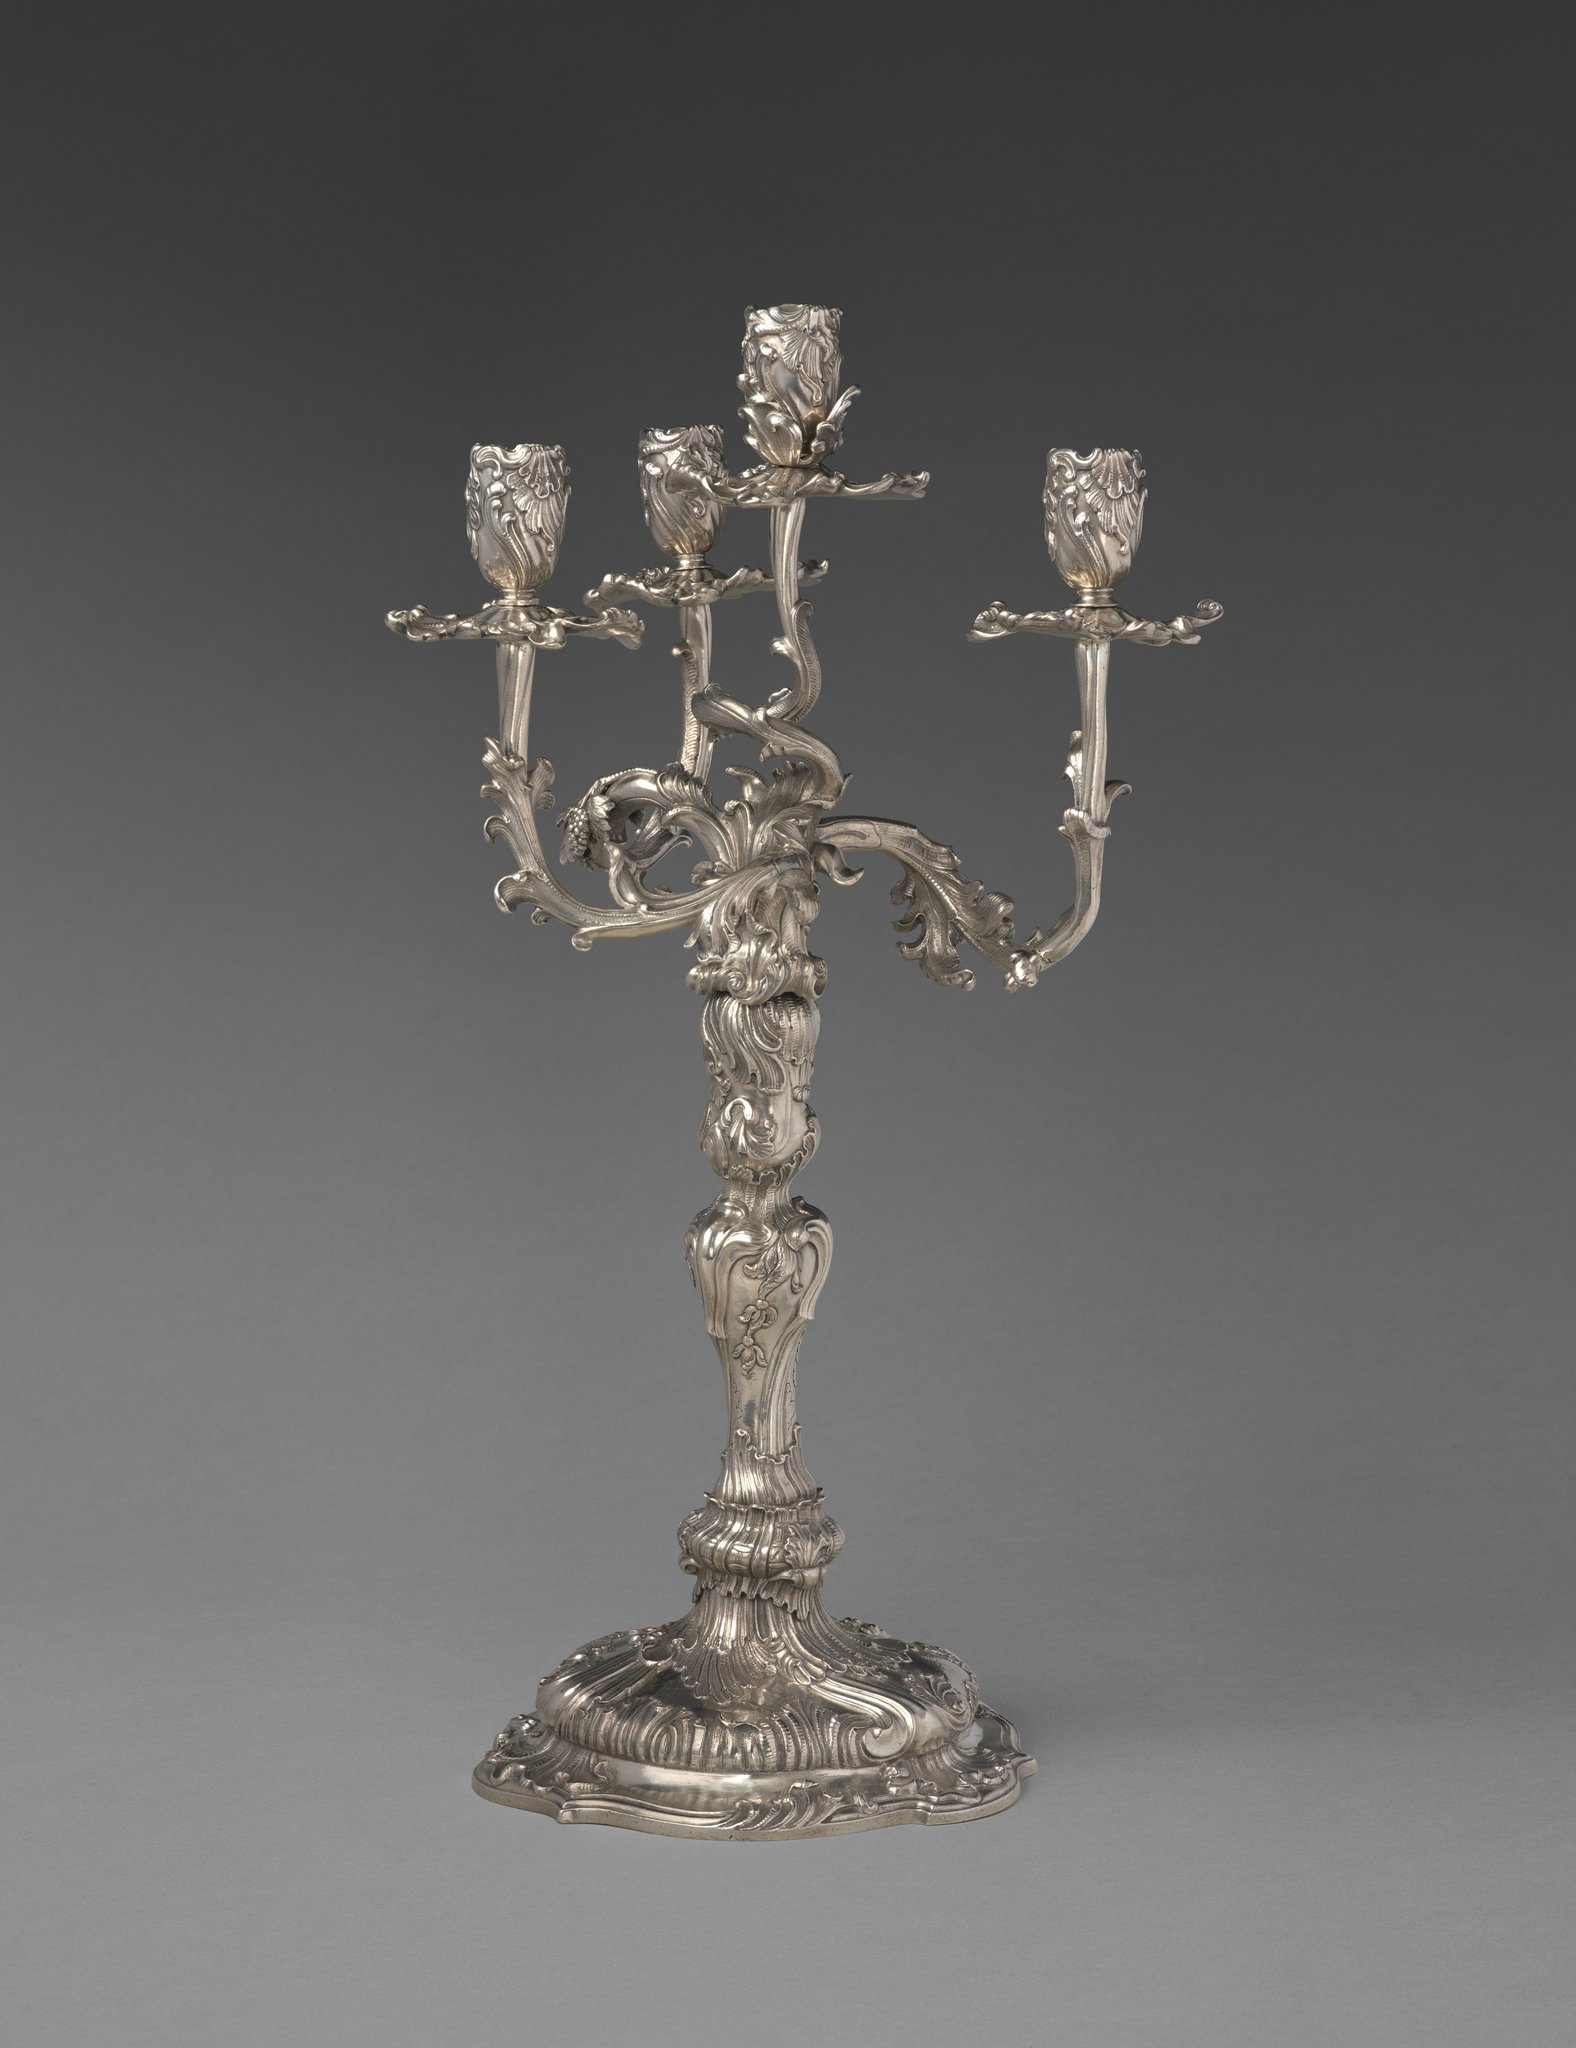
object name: candelabrum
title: Pair of royal German silver four-light candelabra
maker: christian heinrich ingermann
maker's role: maker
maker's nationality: german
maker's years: 1713-1778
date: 1747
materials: silver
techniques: casting, chasing, engraving